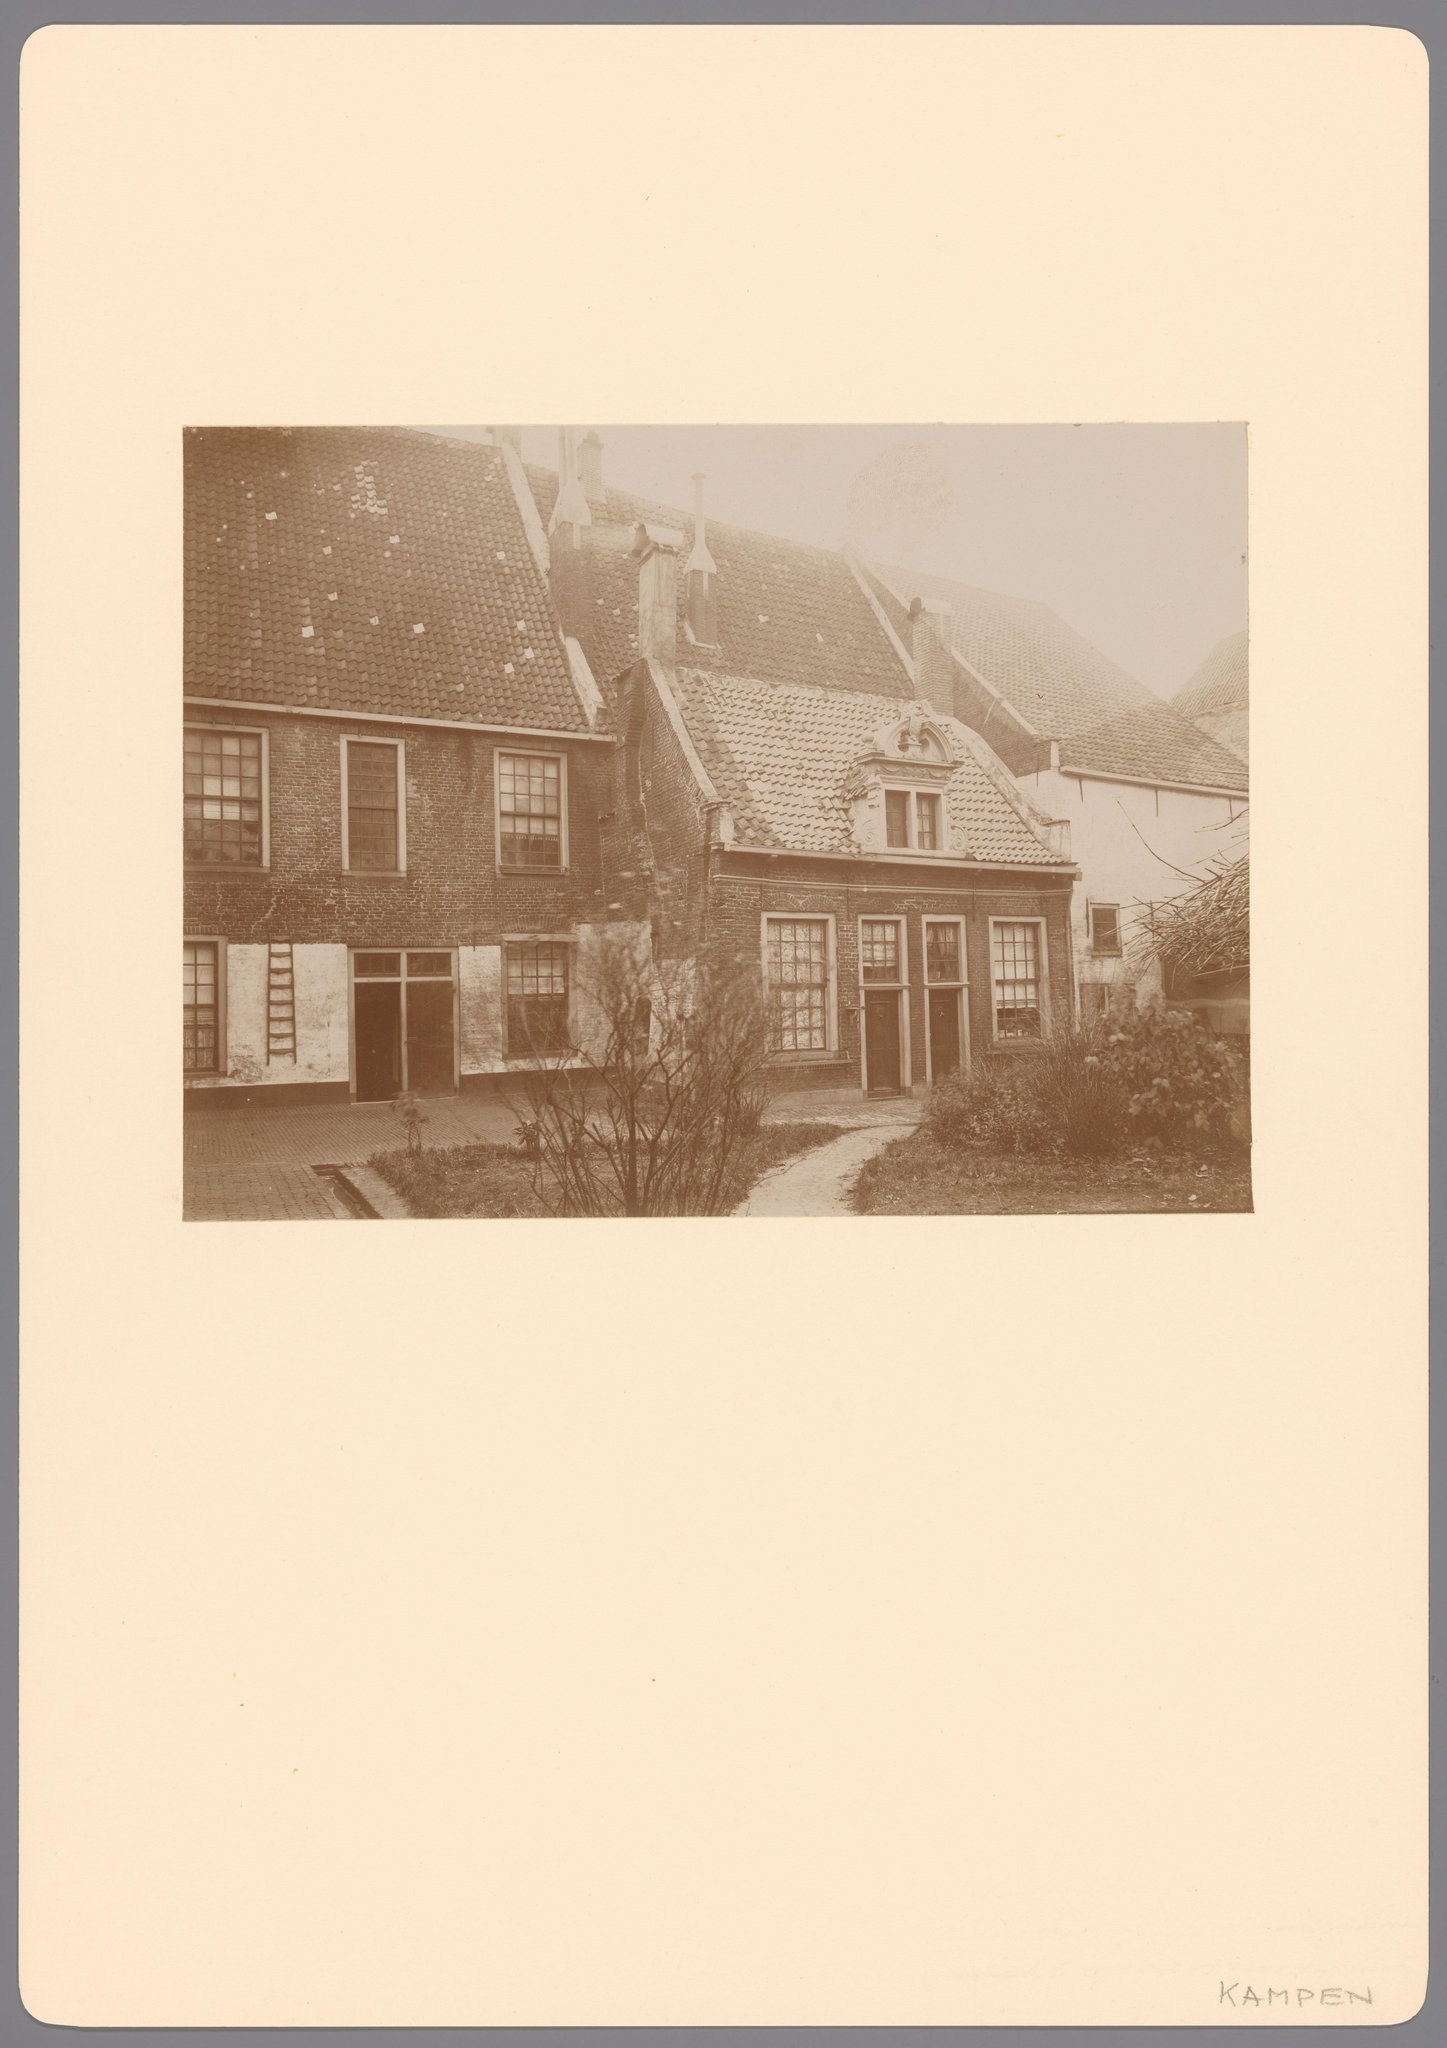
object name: photograph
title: Binnenplaats van het Buiten-Proveniershuis te Kampen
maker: anoniem (monumentenzorg)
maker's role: fotograaf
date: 1896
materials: cardboard, photographic support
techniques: collodion silver print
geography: kampen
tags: urban housing, courtyard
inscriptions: annotation: ‘Kampen’, annotation: ‘Kampen/ Het buitenproveniershuis, gezicht op de binnenplaats’